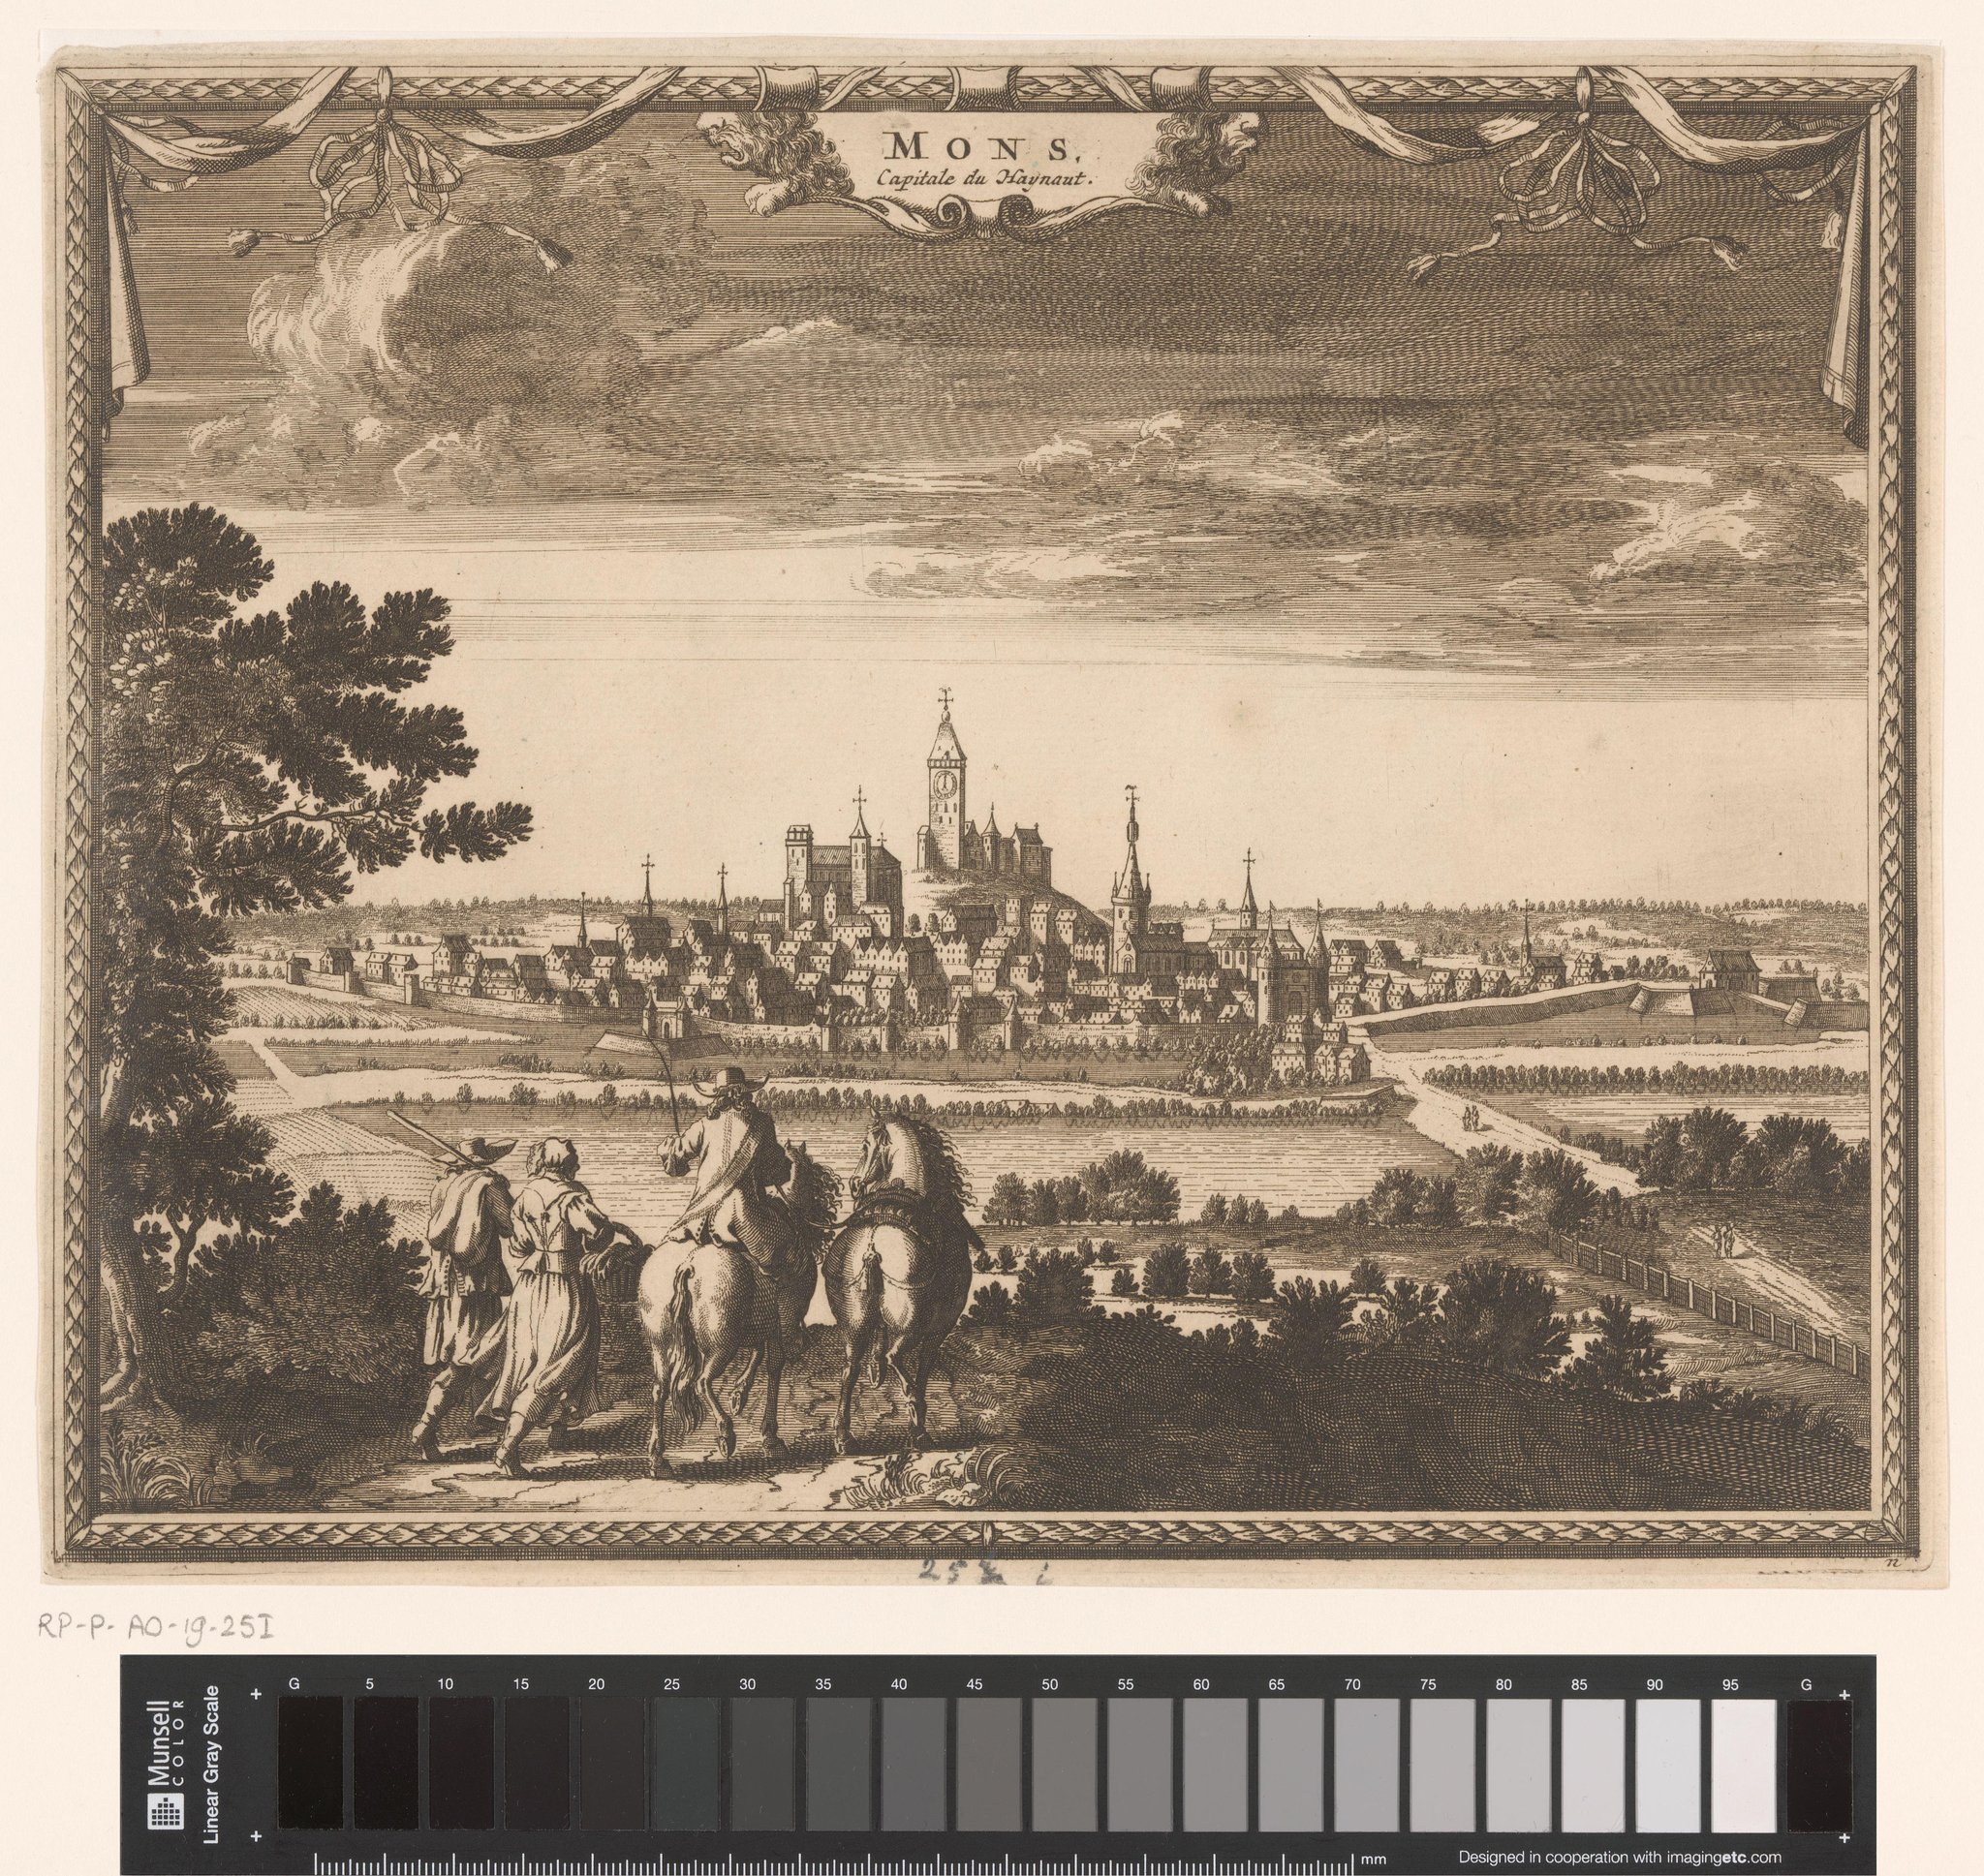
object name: print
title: Gezicht op Bergen (Mons)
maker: Anonymous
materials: paper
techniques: etching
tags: prospect of city, town panorama, silhouette of city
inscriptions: collector's mark: Lugt 2228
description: Huidige staat van prent ook gebruikt in: Aa, Pieter van der. Europa. Leiden: Pieter van der Aa, s.a. [ca. 1715]. En in: Afbeeldinghe der voornaemste steeden van Nederlant / Les principales villes des Pais-bas. Amsteram: Covens & Mortier, s.a. [na 1721]. En in: Les forces de l'Europe, Asie, Afrique et Amerique, ou description des principales villes, avec leurs fortifications (…). 20 delen. Leiden : Pieter van der Aa, 1726. Huidige staat met apart gedrukte sierrand gebruikt in: Aa, Pieter van der. La galerie agreable du monde (...). 66 delen. Leiden: Pieter van der Aa, 1728, dl. 16.